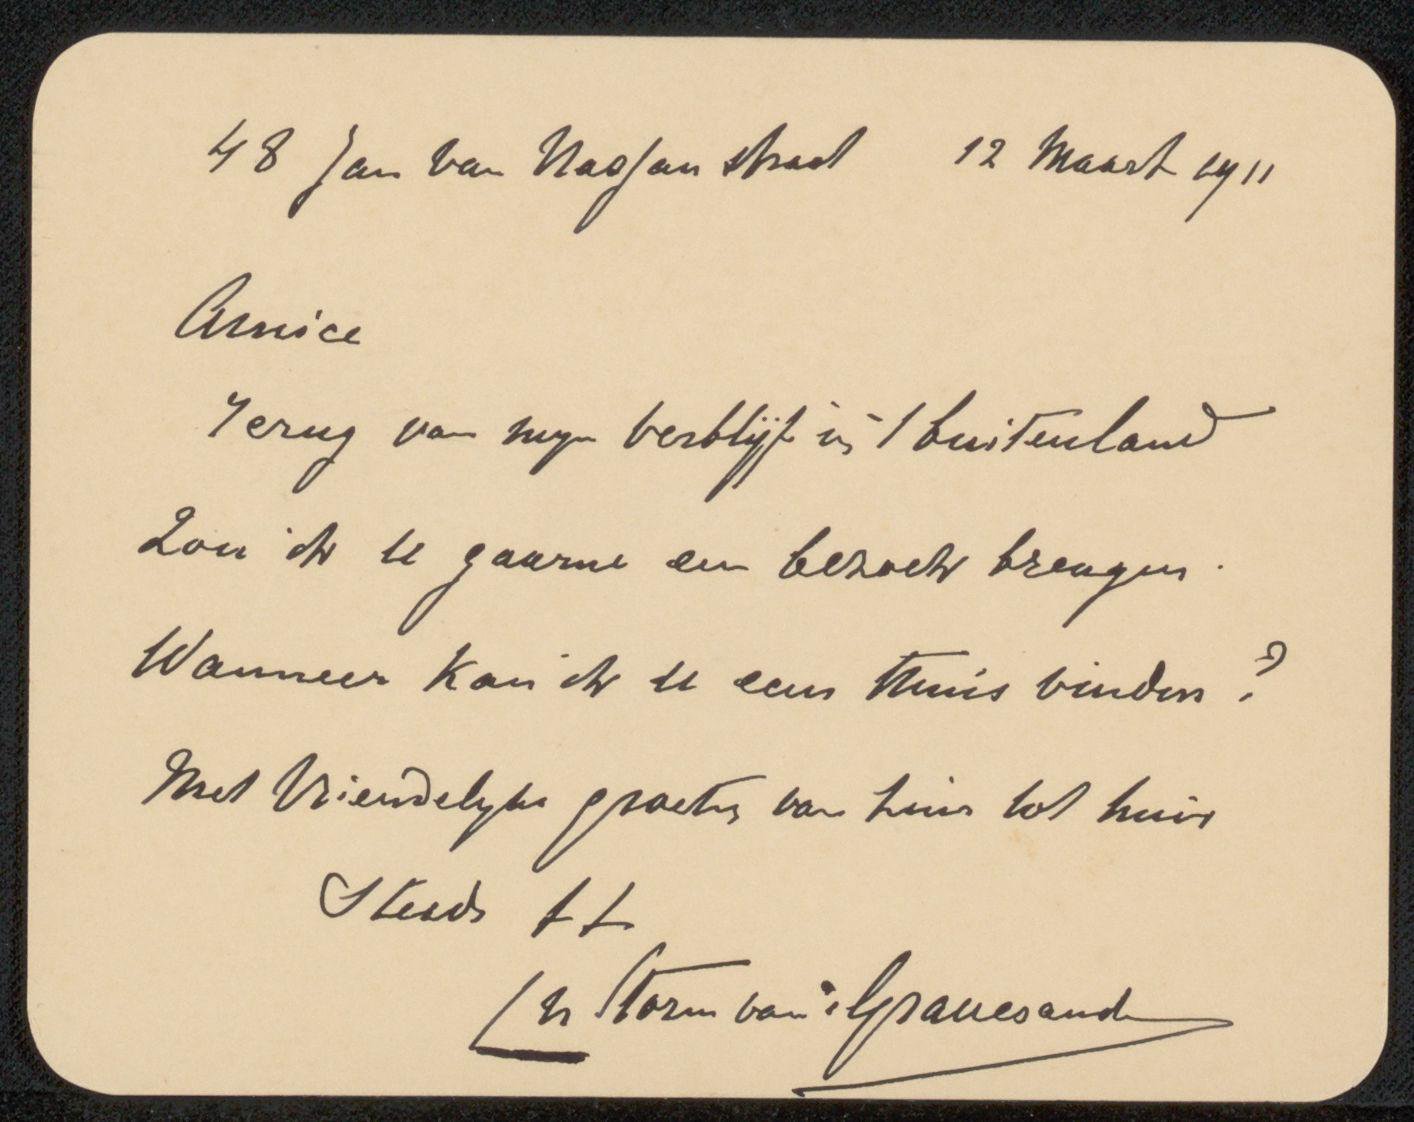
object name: letter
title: Brief aan Philip Zilcken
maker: carel nicolaas storm van s-gravesande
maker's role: draughtsman, print maker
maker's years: 1841-1924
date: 1911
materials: cardboard, ink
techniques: pen, writing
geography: the hague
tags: painter, philip zilcken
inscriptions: collector's mark: ‘RPK’